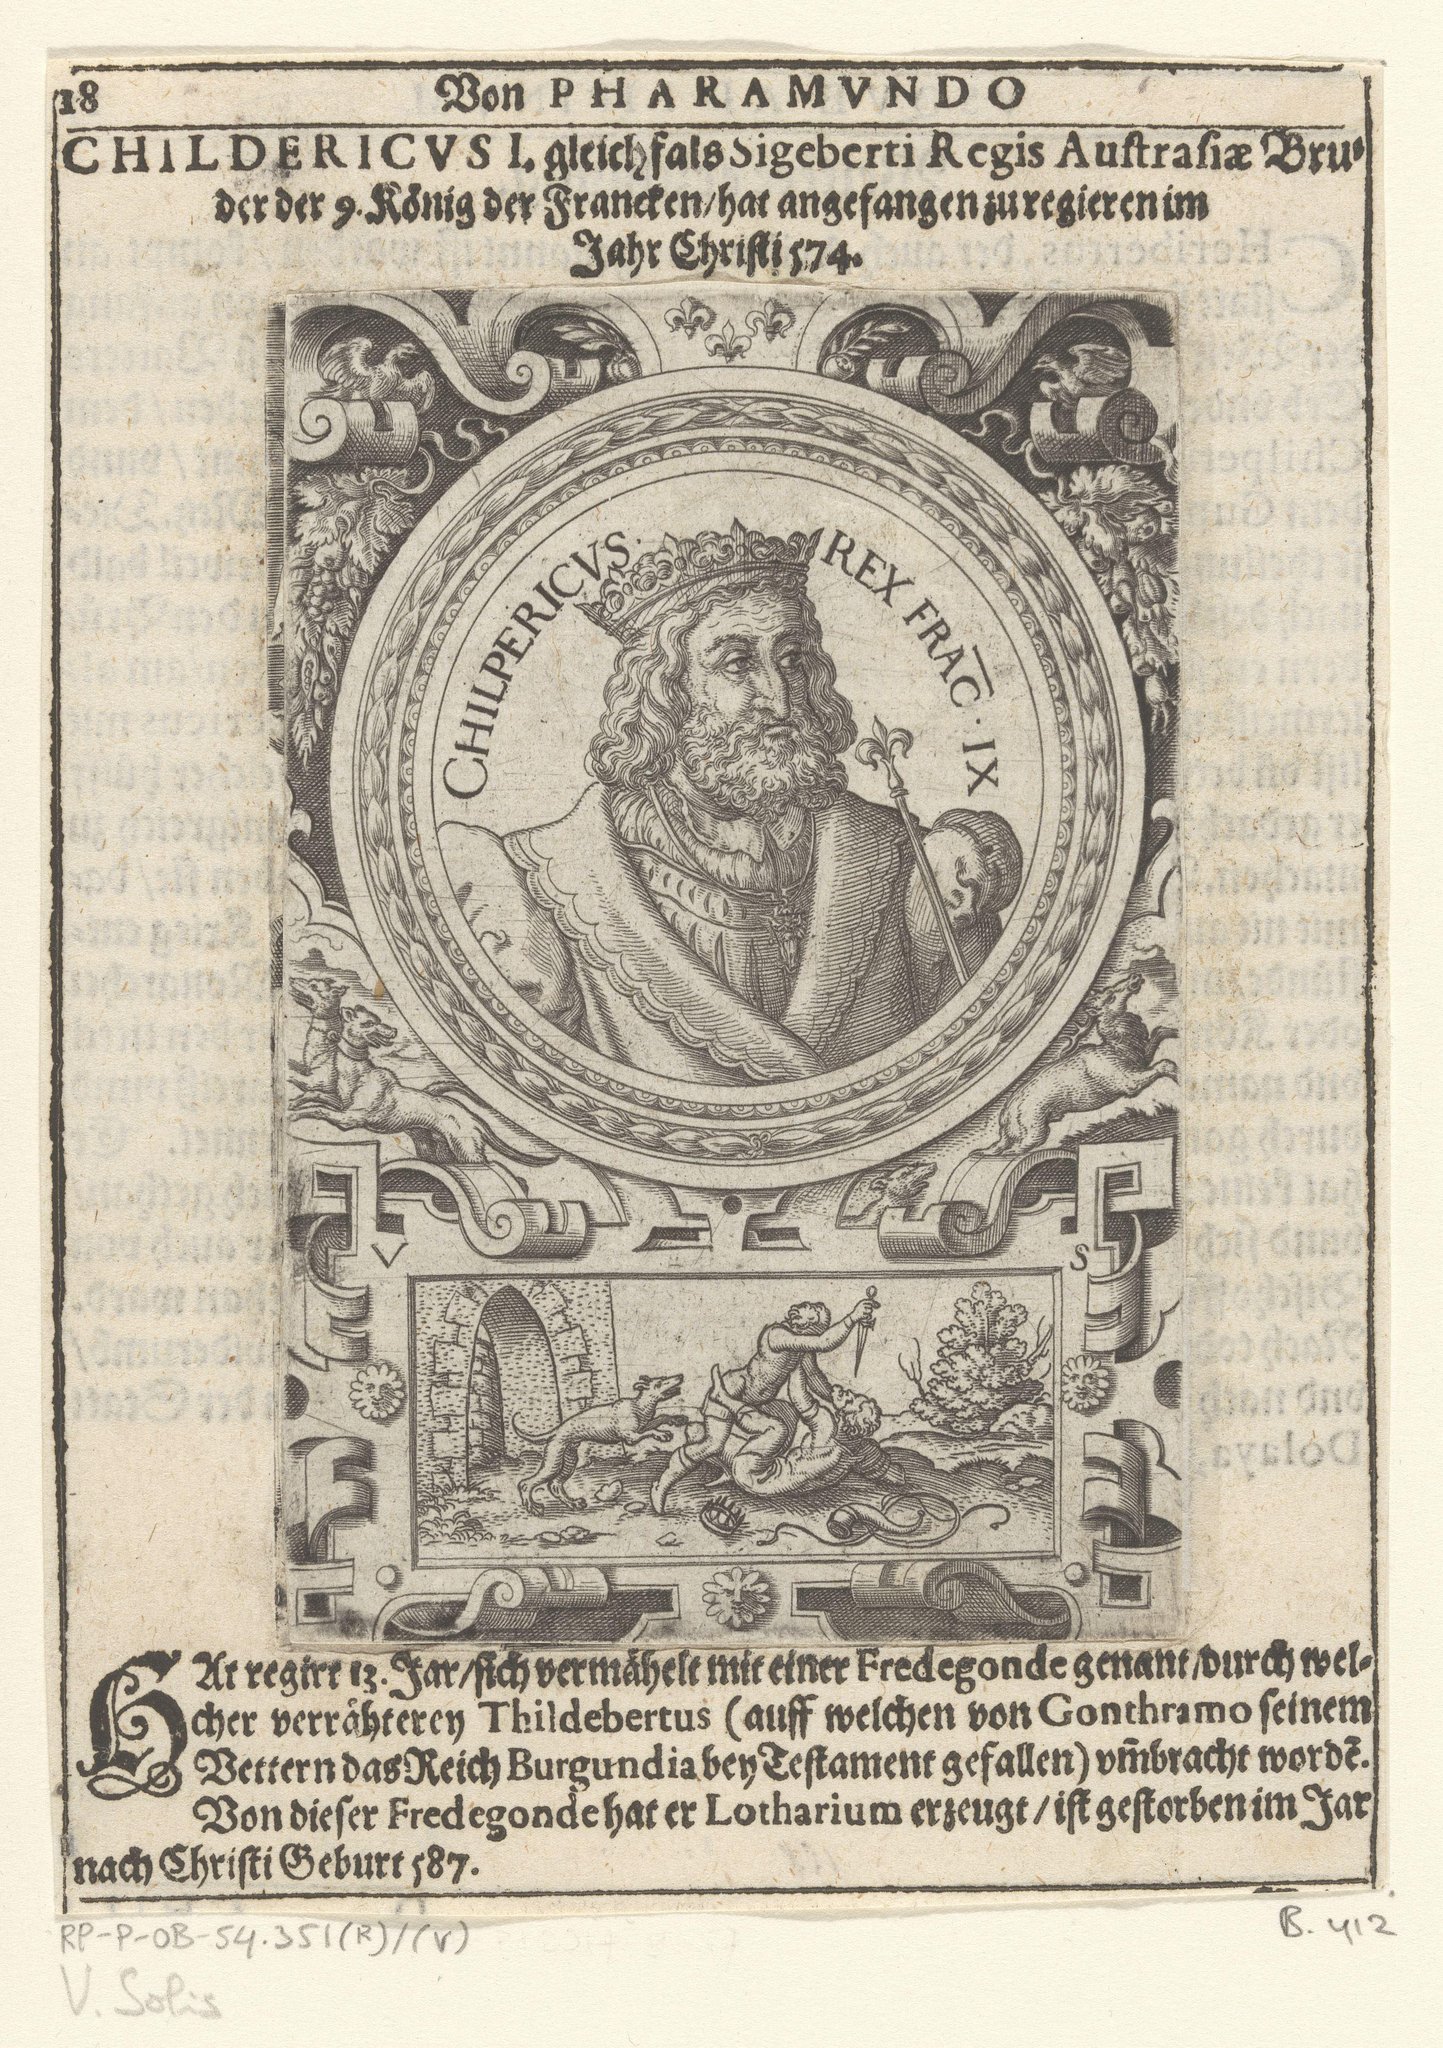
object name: print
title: Portret van Clovis II, koning van Neustrië en Bourgondië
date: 1598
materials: paper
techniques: engraving, etching, intaglio, letterpress printing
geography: nuremberg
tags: scrollwork, strapwork ~ ornament, historical persons, ruler, sovereign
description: Prent afkomstig uit de publicatie: Michael Eizinger. Könige in Frankreich. Keulen: Johann Bussemacher, 1598. De publicatie bevat prenten van Jost Amman en Virgil Solis. Het portret van Clovis II lijkt te zijn afgedrukt op de verkeerde pagina. De juiste prent behorend bij deze pagina is eroverheen gemonteerd: RP-P-OB-54.351(V). De opgeplakte prent met het portret van Chilperik I is hier beschreven als versozijde maar is in werkelijkheid gemonteerd op de rectozijde van het blad, over het portret van Clovis II heen. Omgekeerd is bij de pagina met tekst over Clovis II zijn portret over dat van Chilperik I heen gemonteerd: RP-P-OB-54.354(R)/RP-P-OB-54.354(V).